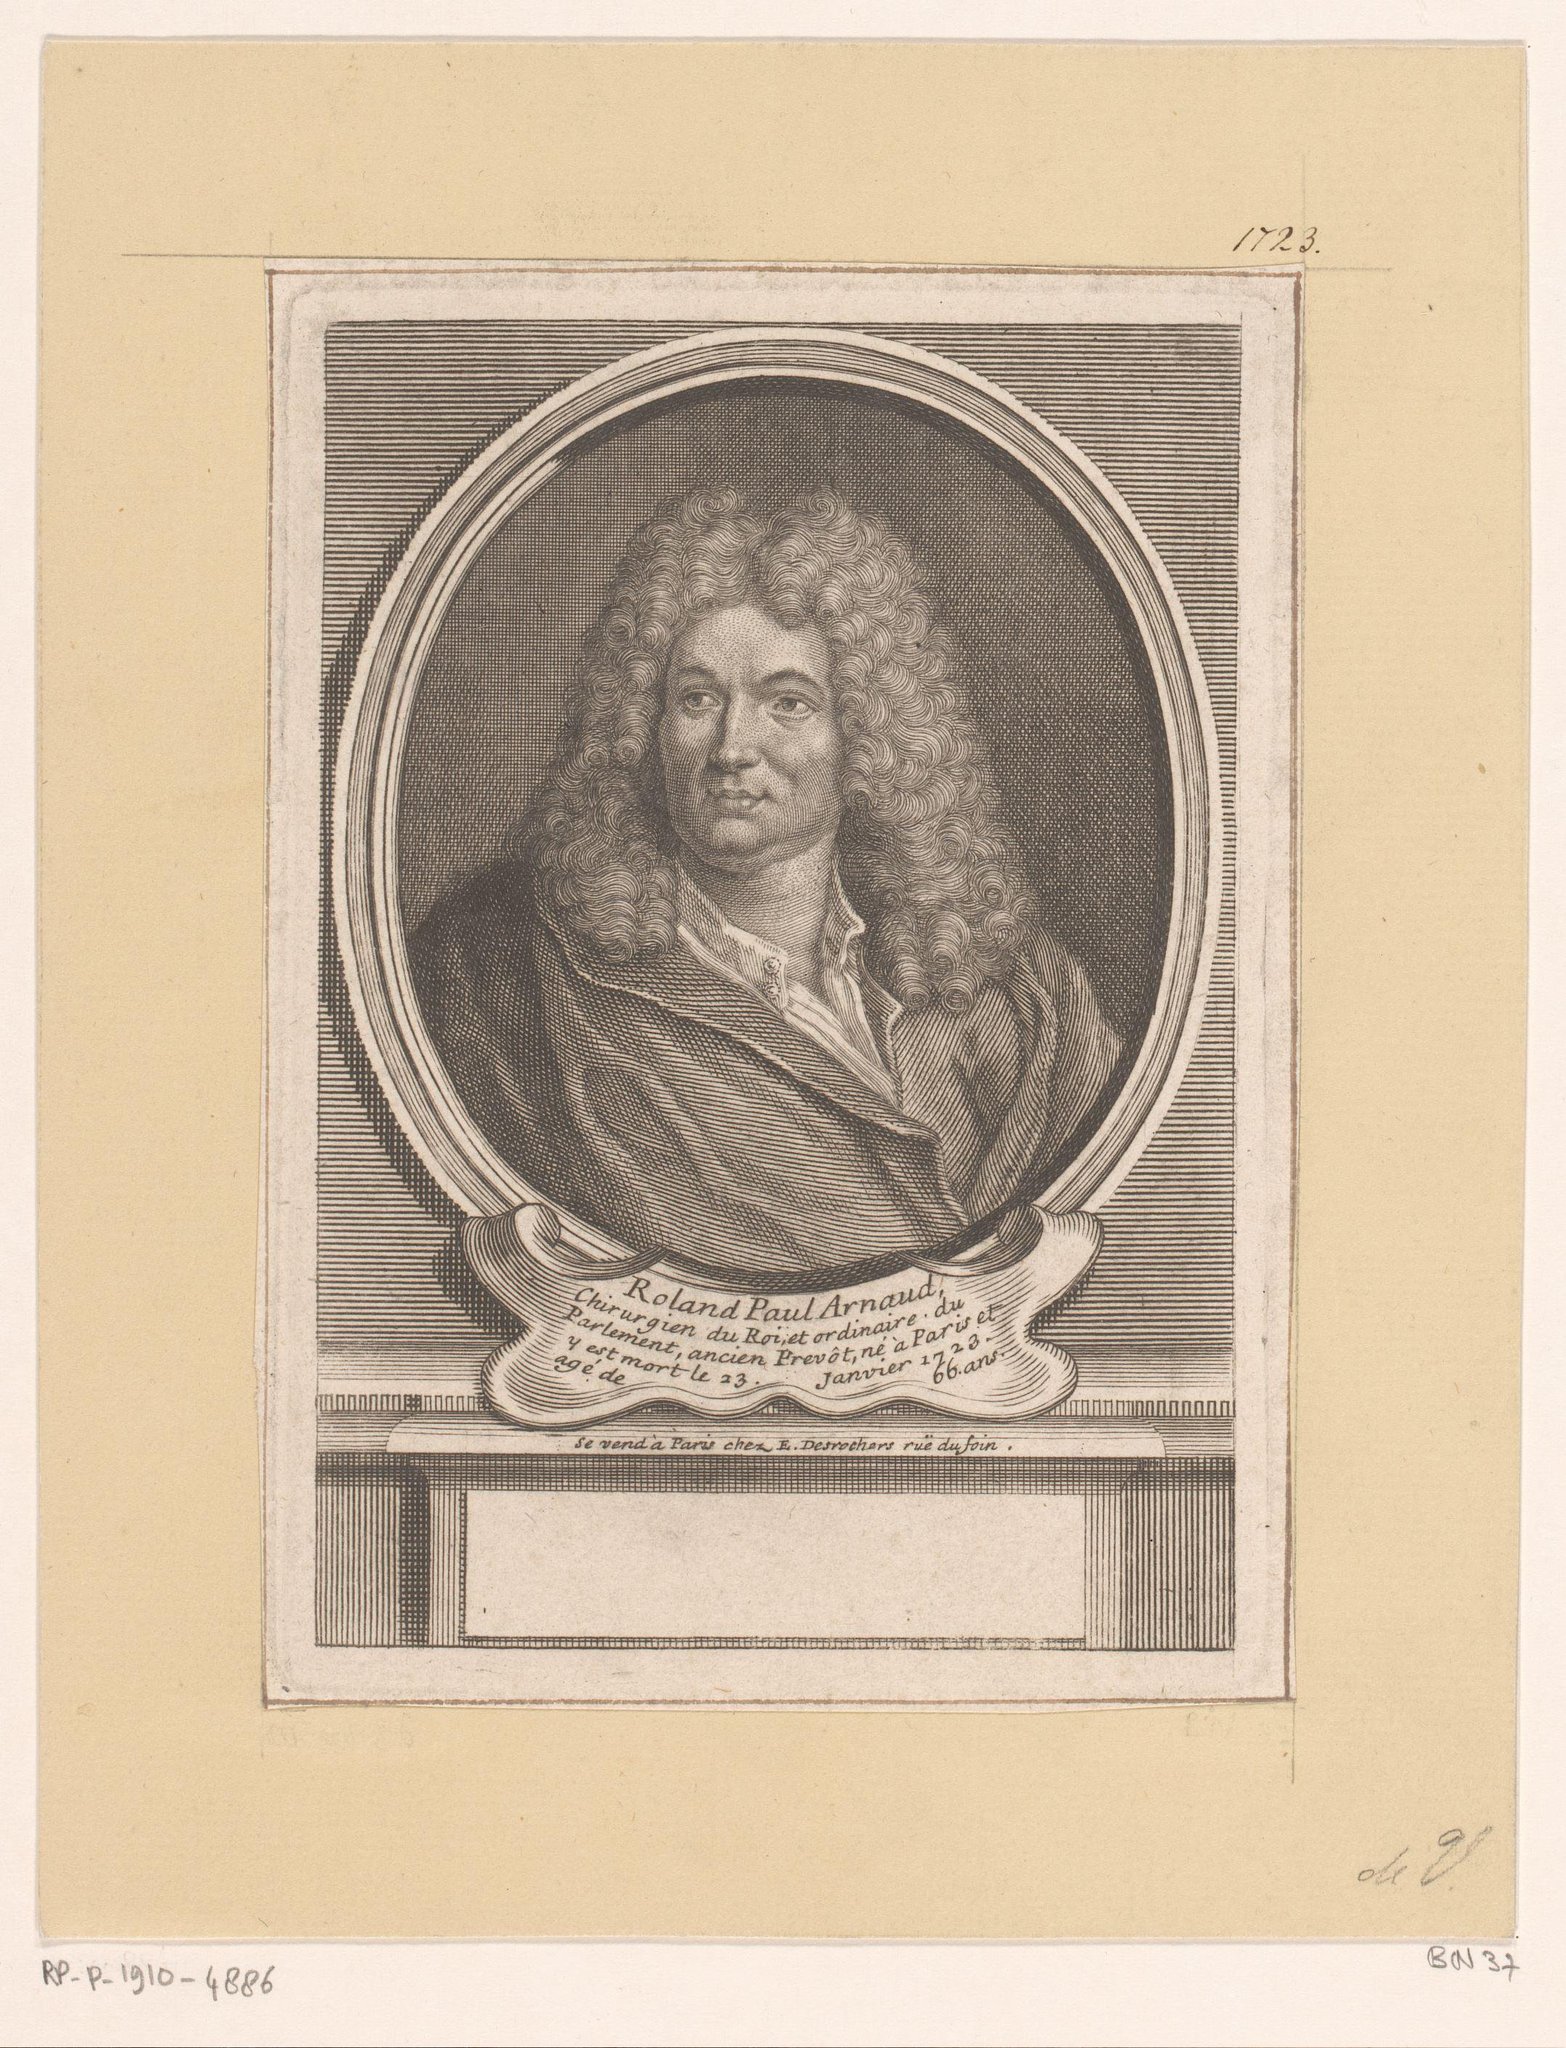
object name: print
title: Portret van Roland Paul Arnaud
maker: étienne desrochers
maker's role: print maker, publisher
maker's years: 1668-1741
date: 1726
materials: paper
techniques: engraving, etching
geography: paris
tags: historical persons, barber; surgeon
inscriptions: collector's mark: Lugt 2228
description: Behoort waarschijnlijk tot een serie portretten, grotendeels door Etienne Desrochers, getiteld: 'Recueil de portraits de personnes qui se sont distinguées tant dans les Armes que dans Belles-Lettres et les Arts, comme aussi la famille royale de France et autres cours étrangères'. De serie werd initieel uitgegeven door Desrochers en aangekondigd in 'Mercure' in mei 1726, p. 985. Echter was Desrochers reeds enkele jaren eerder begonnen met het uitgeven van de serie. Na de dood van Desrochers werd de serie voortgezet door Gilles Edme Petit. Een latere staat werd uitgegeven door Jean François Daumont in Parijs.